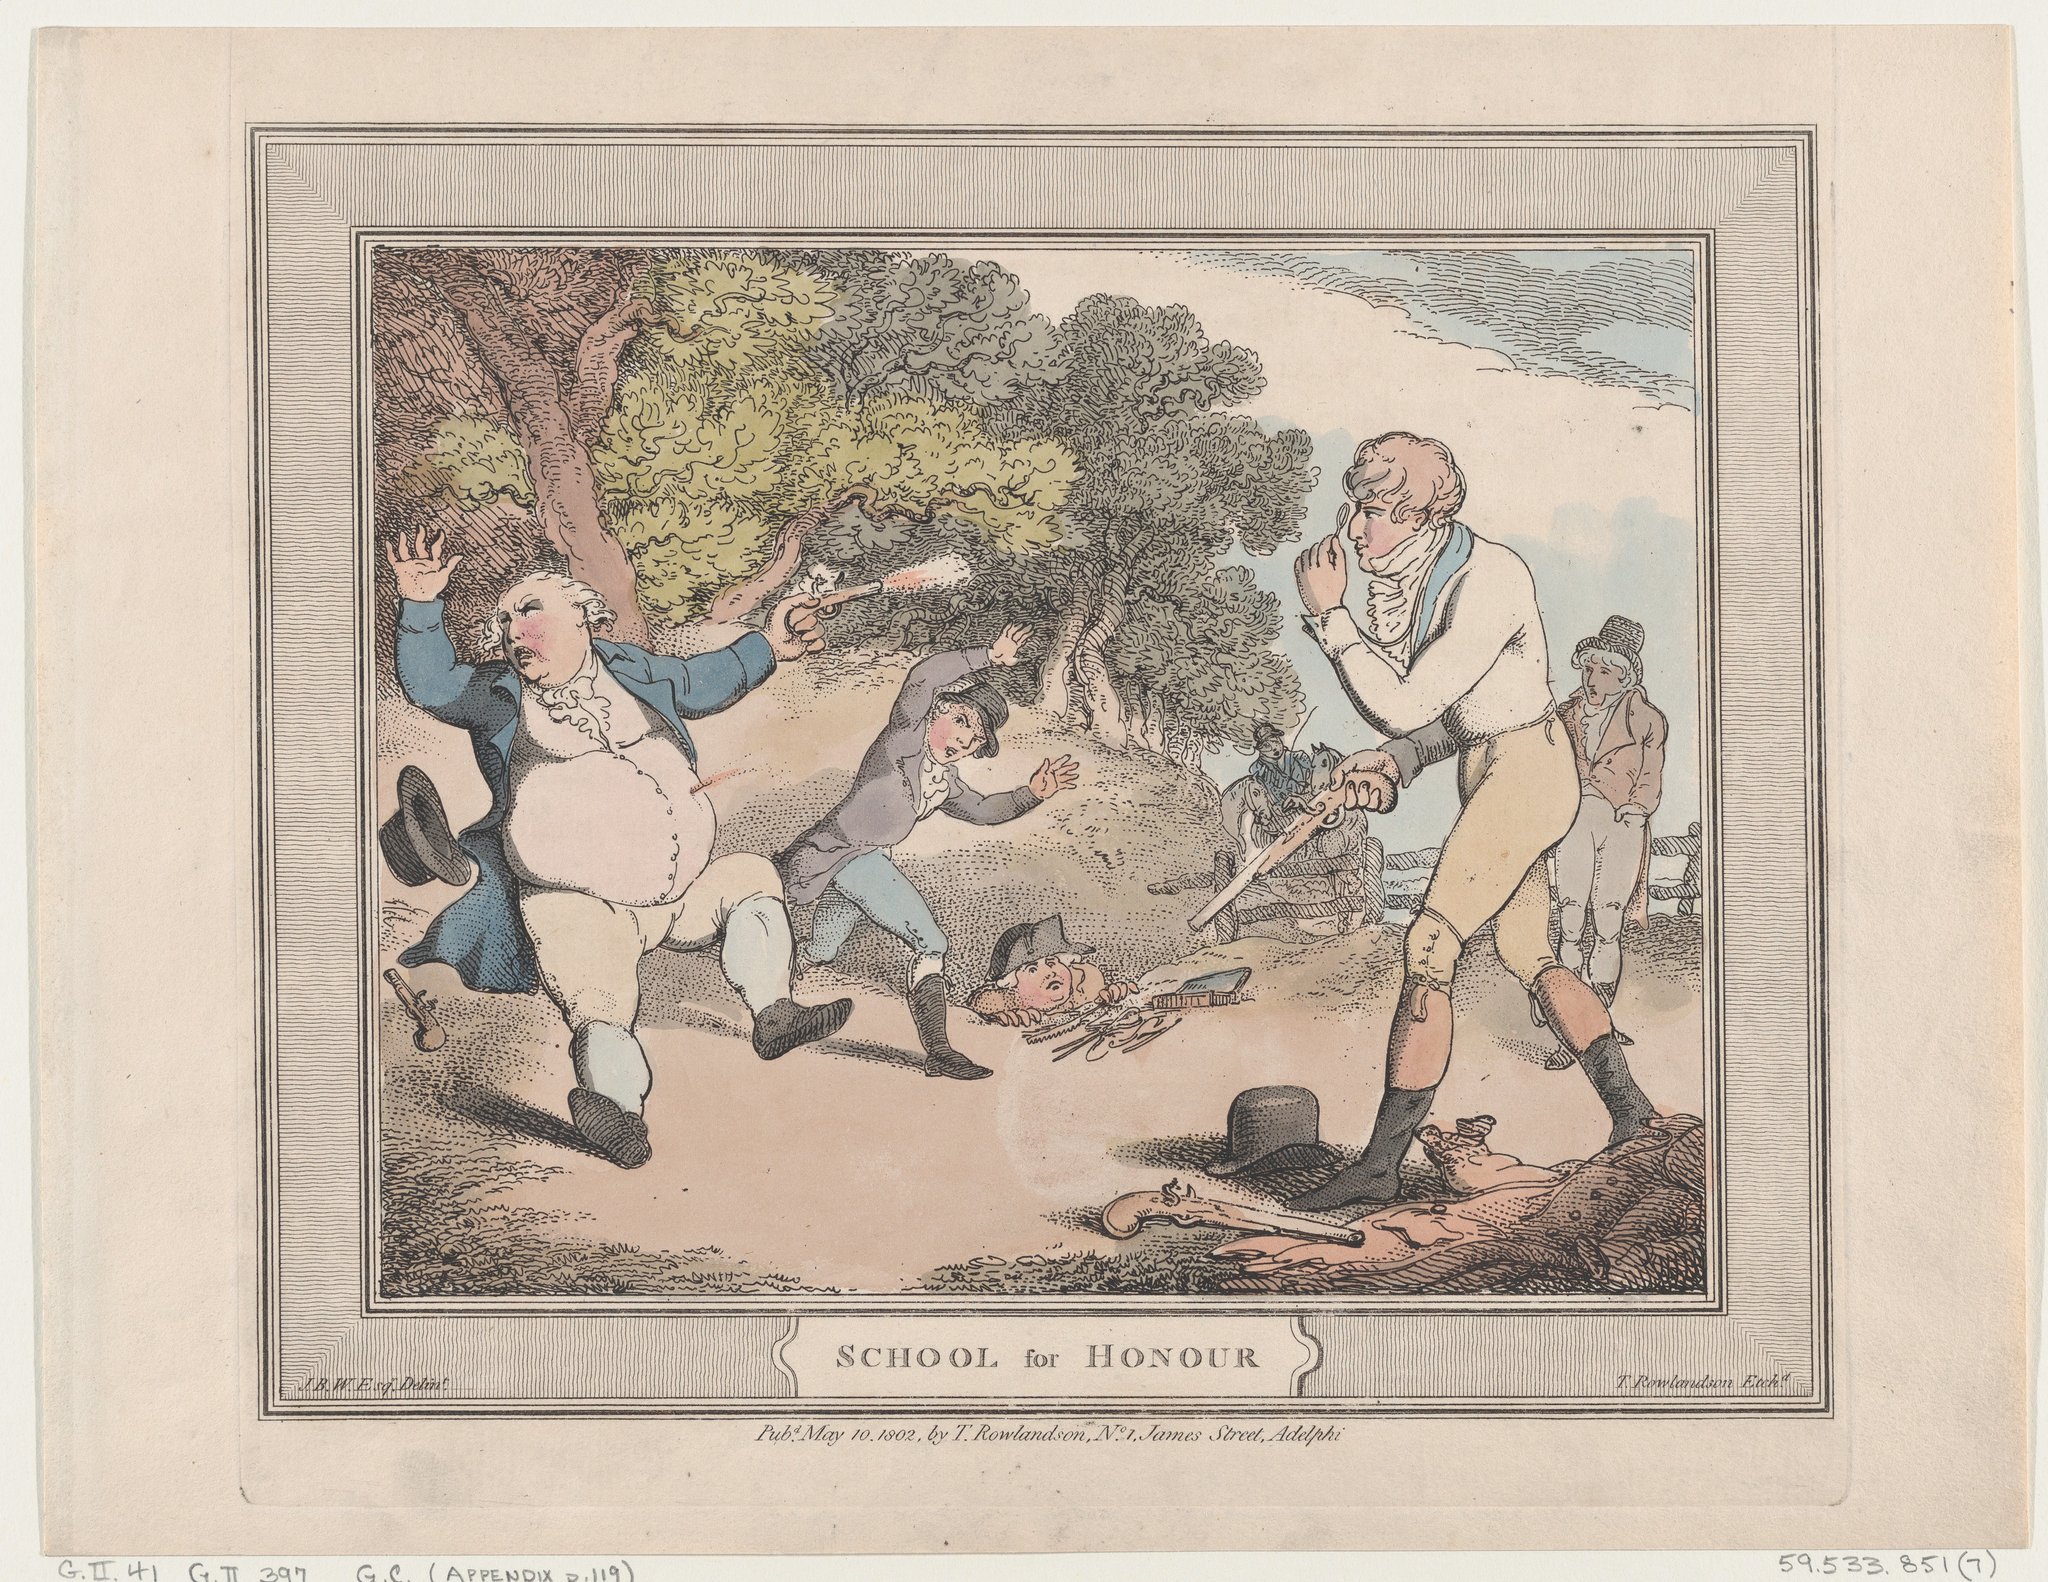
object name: print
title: School for Honour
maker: thomas rowlandson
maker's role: artist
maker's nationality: british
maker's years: 1757-1827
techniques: etching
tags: satire,firearms,men